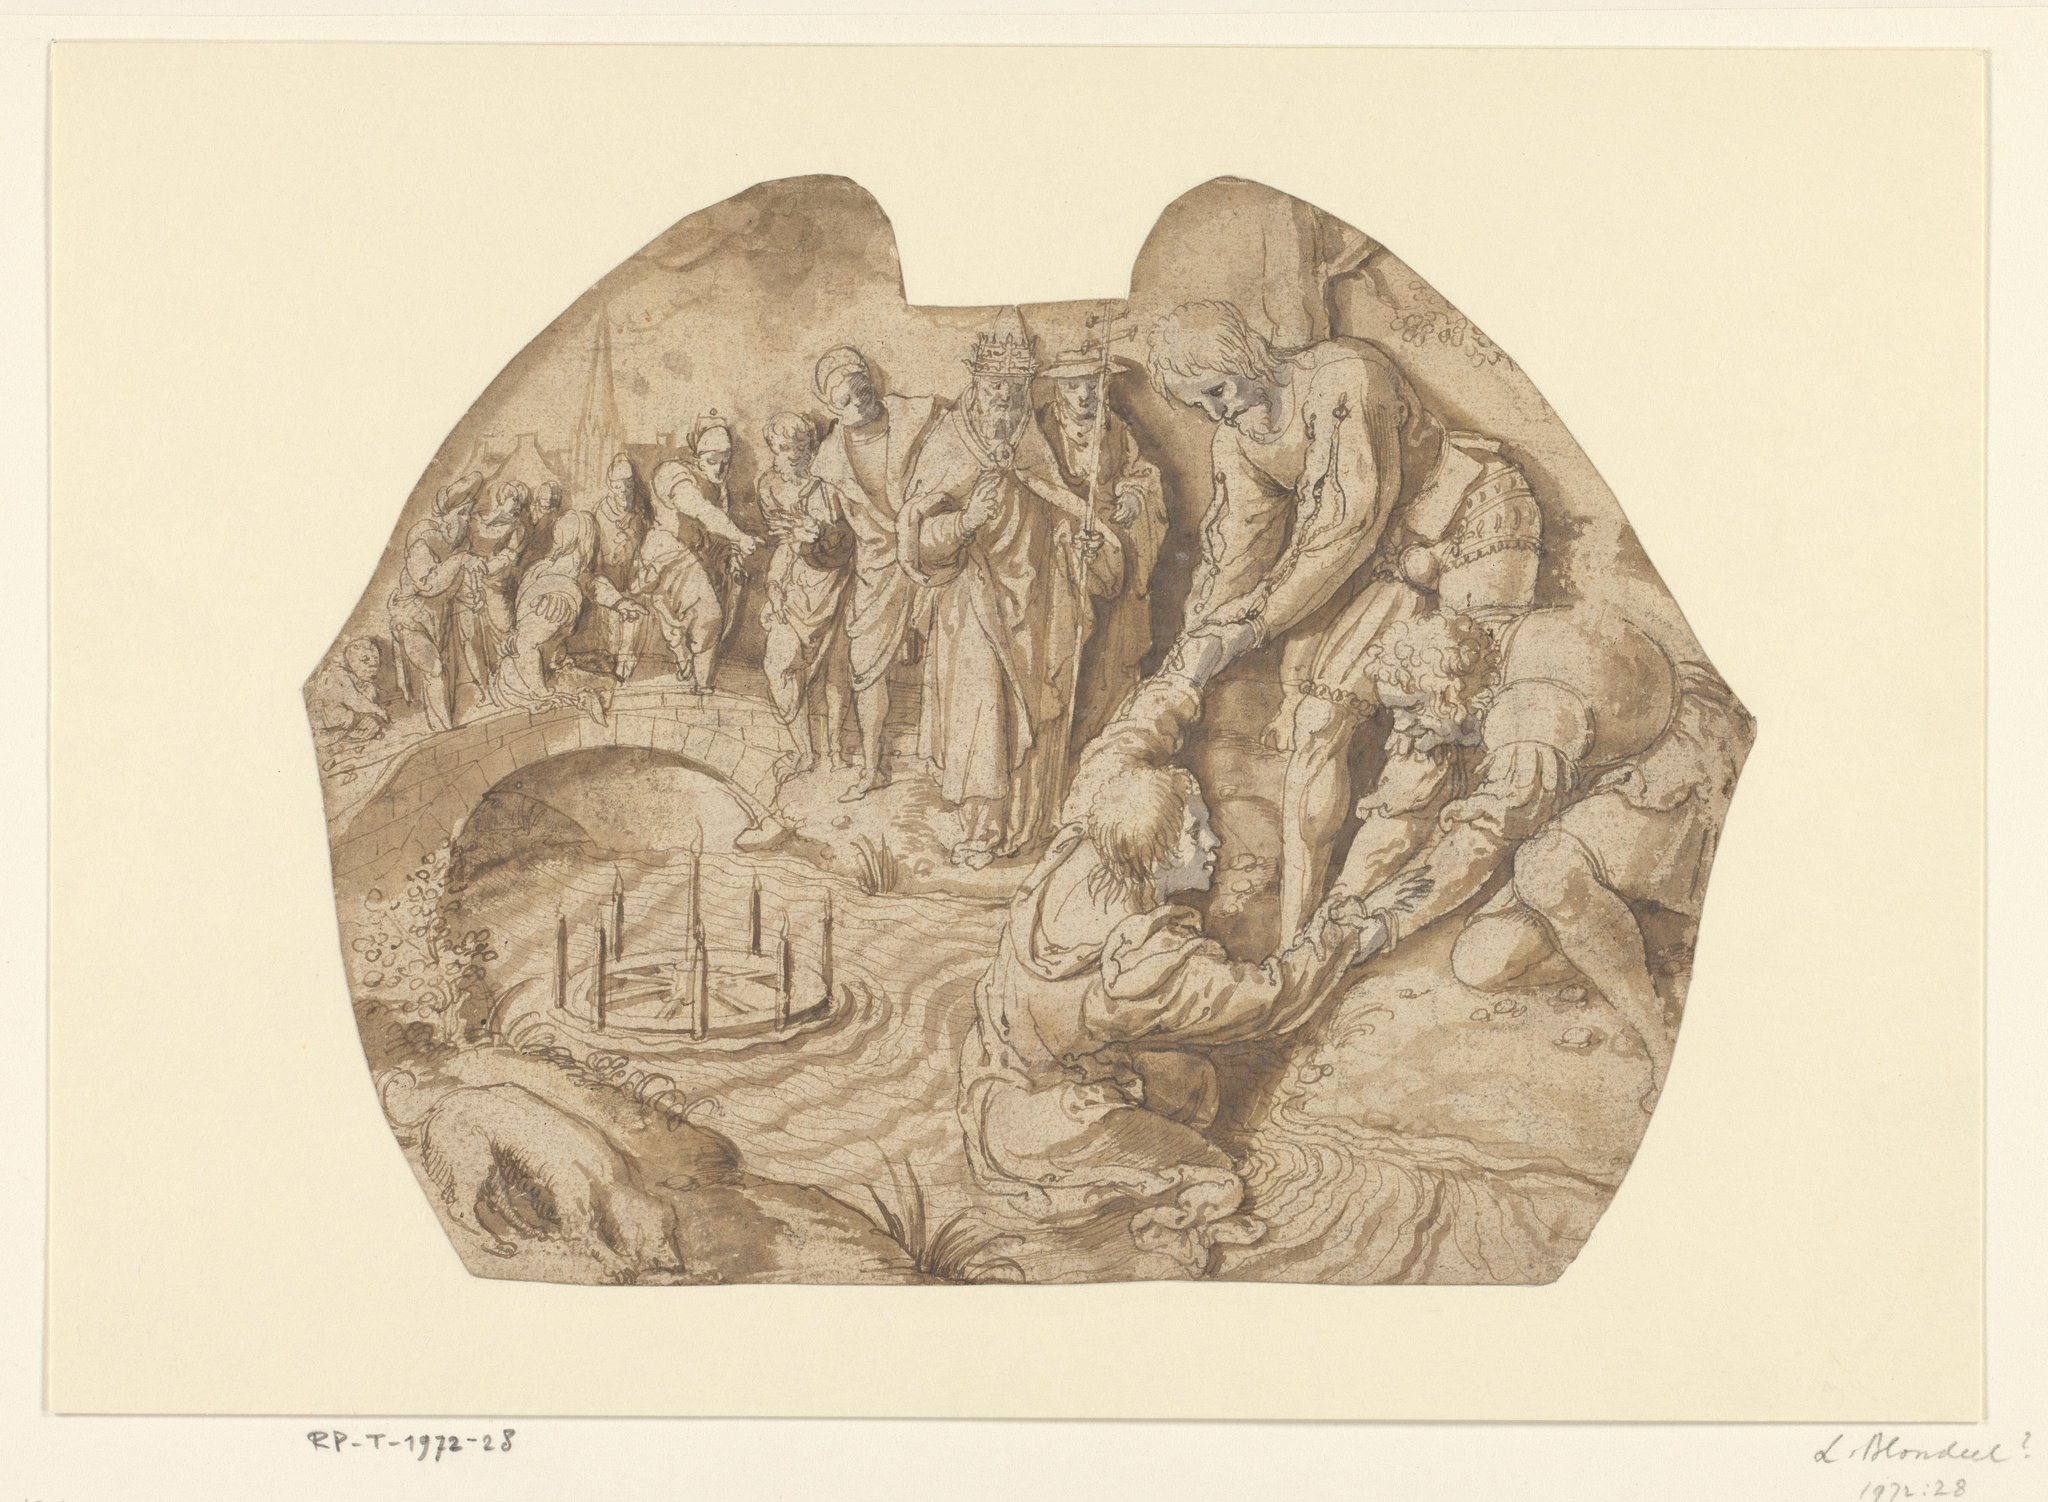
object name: drawing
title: Redding van de heilige Donatianus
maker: lancelot blondeel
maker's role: draughtsman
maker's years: 1498-1561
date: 1545-1550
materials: ink, paper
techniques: brush, pen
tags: male saints (with name)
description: De wonderbaarlijke redding van de heilige Donatianus als ontwerp voor borduurwerk op een koorkapschild.